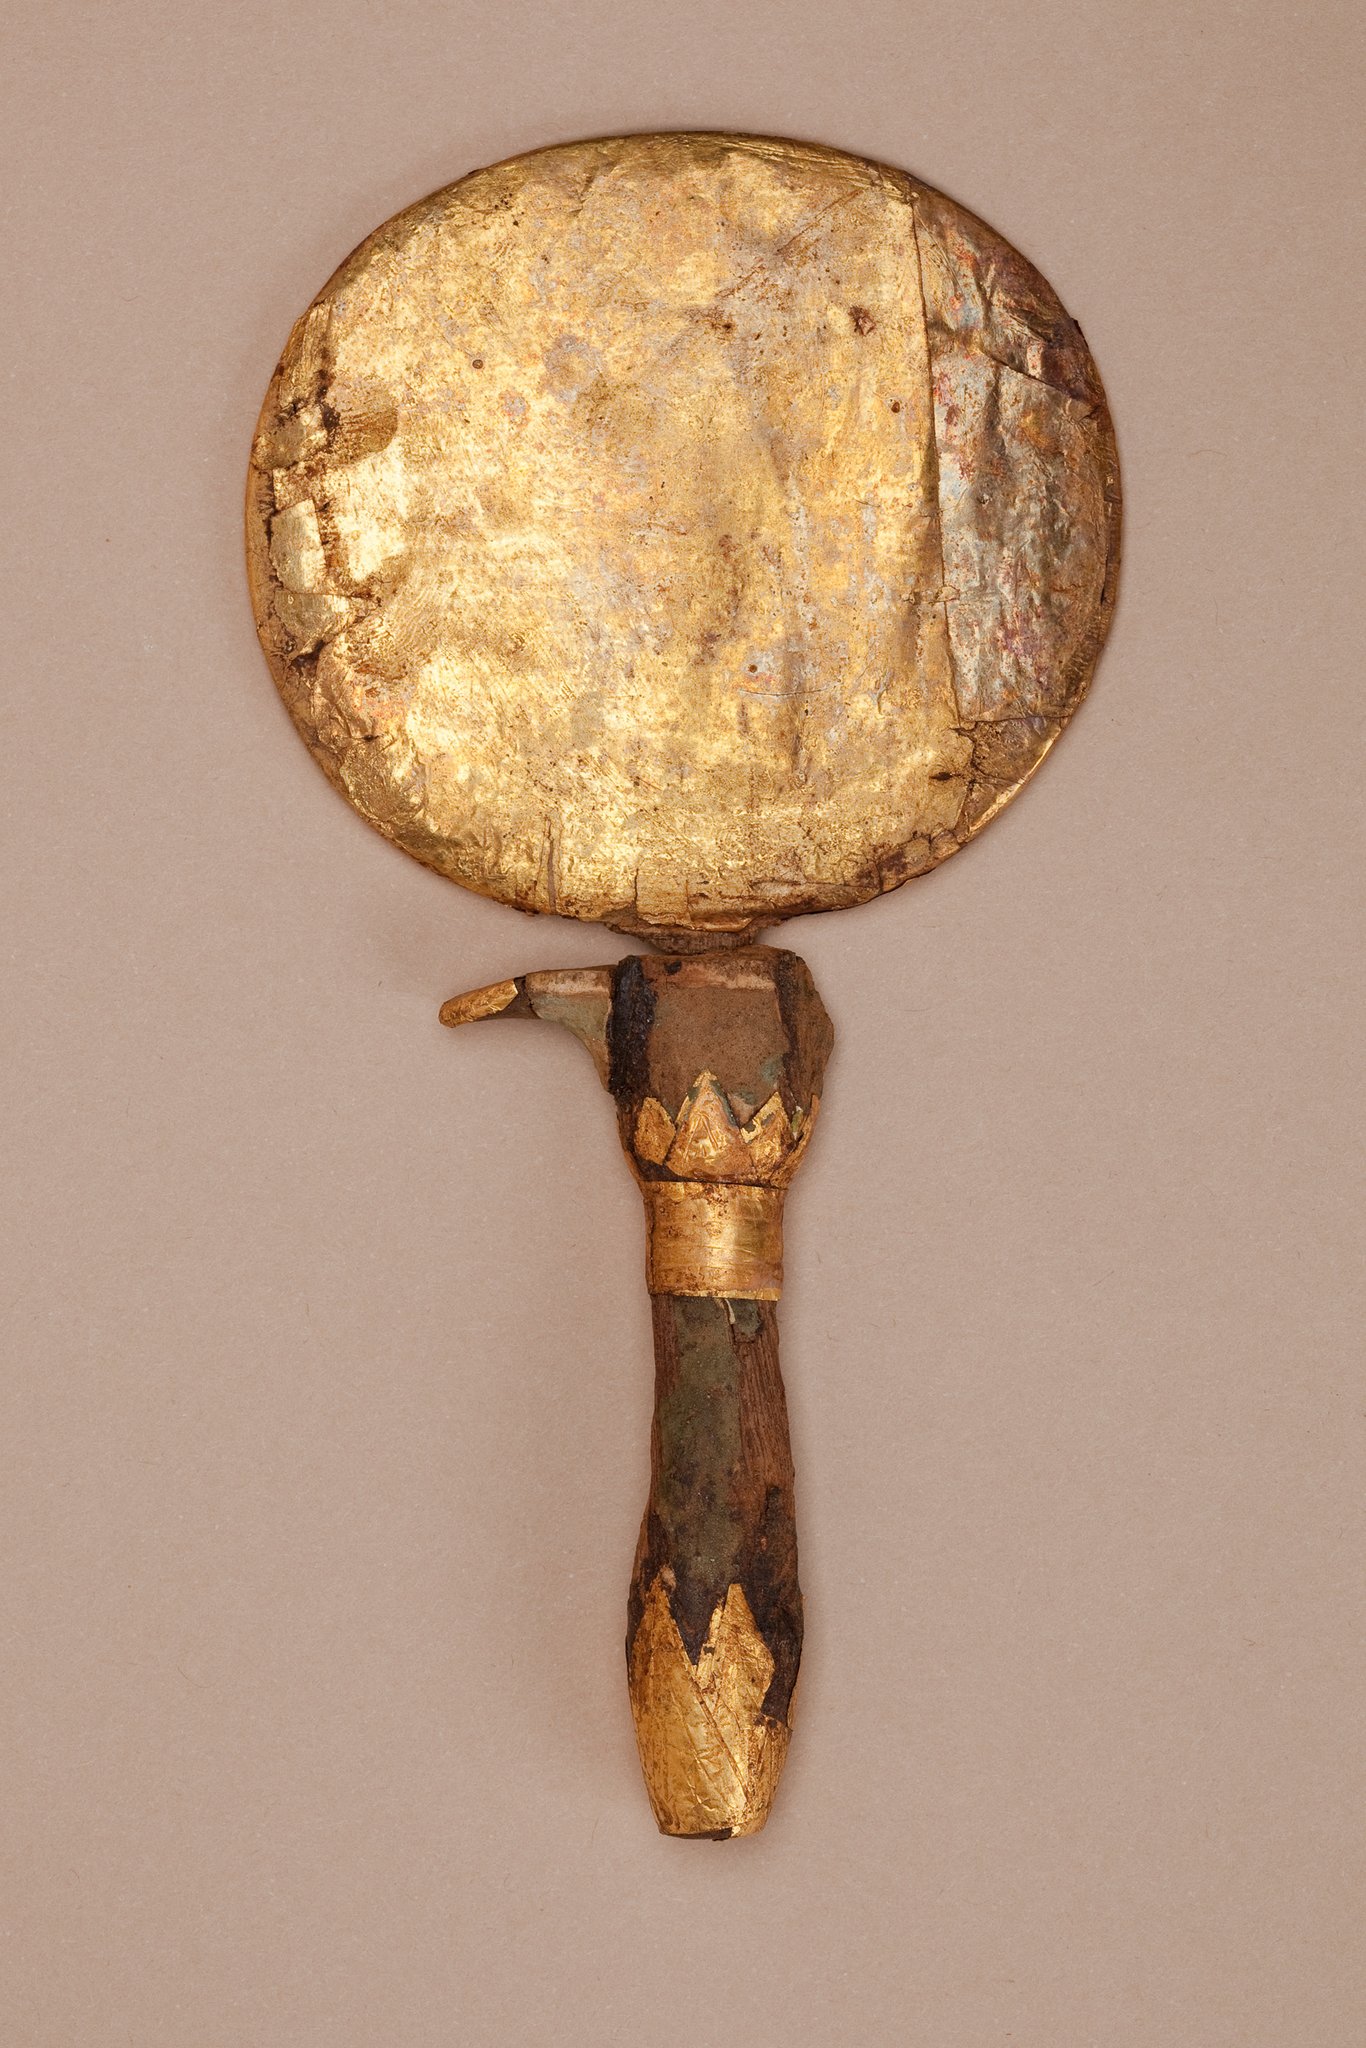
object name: model mirror, hapiankhtifi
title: Model mirror of Hapiankhtifi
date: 1981-1802 BCE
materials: gold leaf, paint, wood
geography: egypt